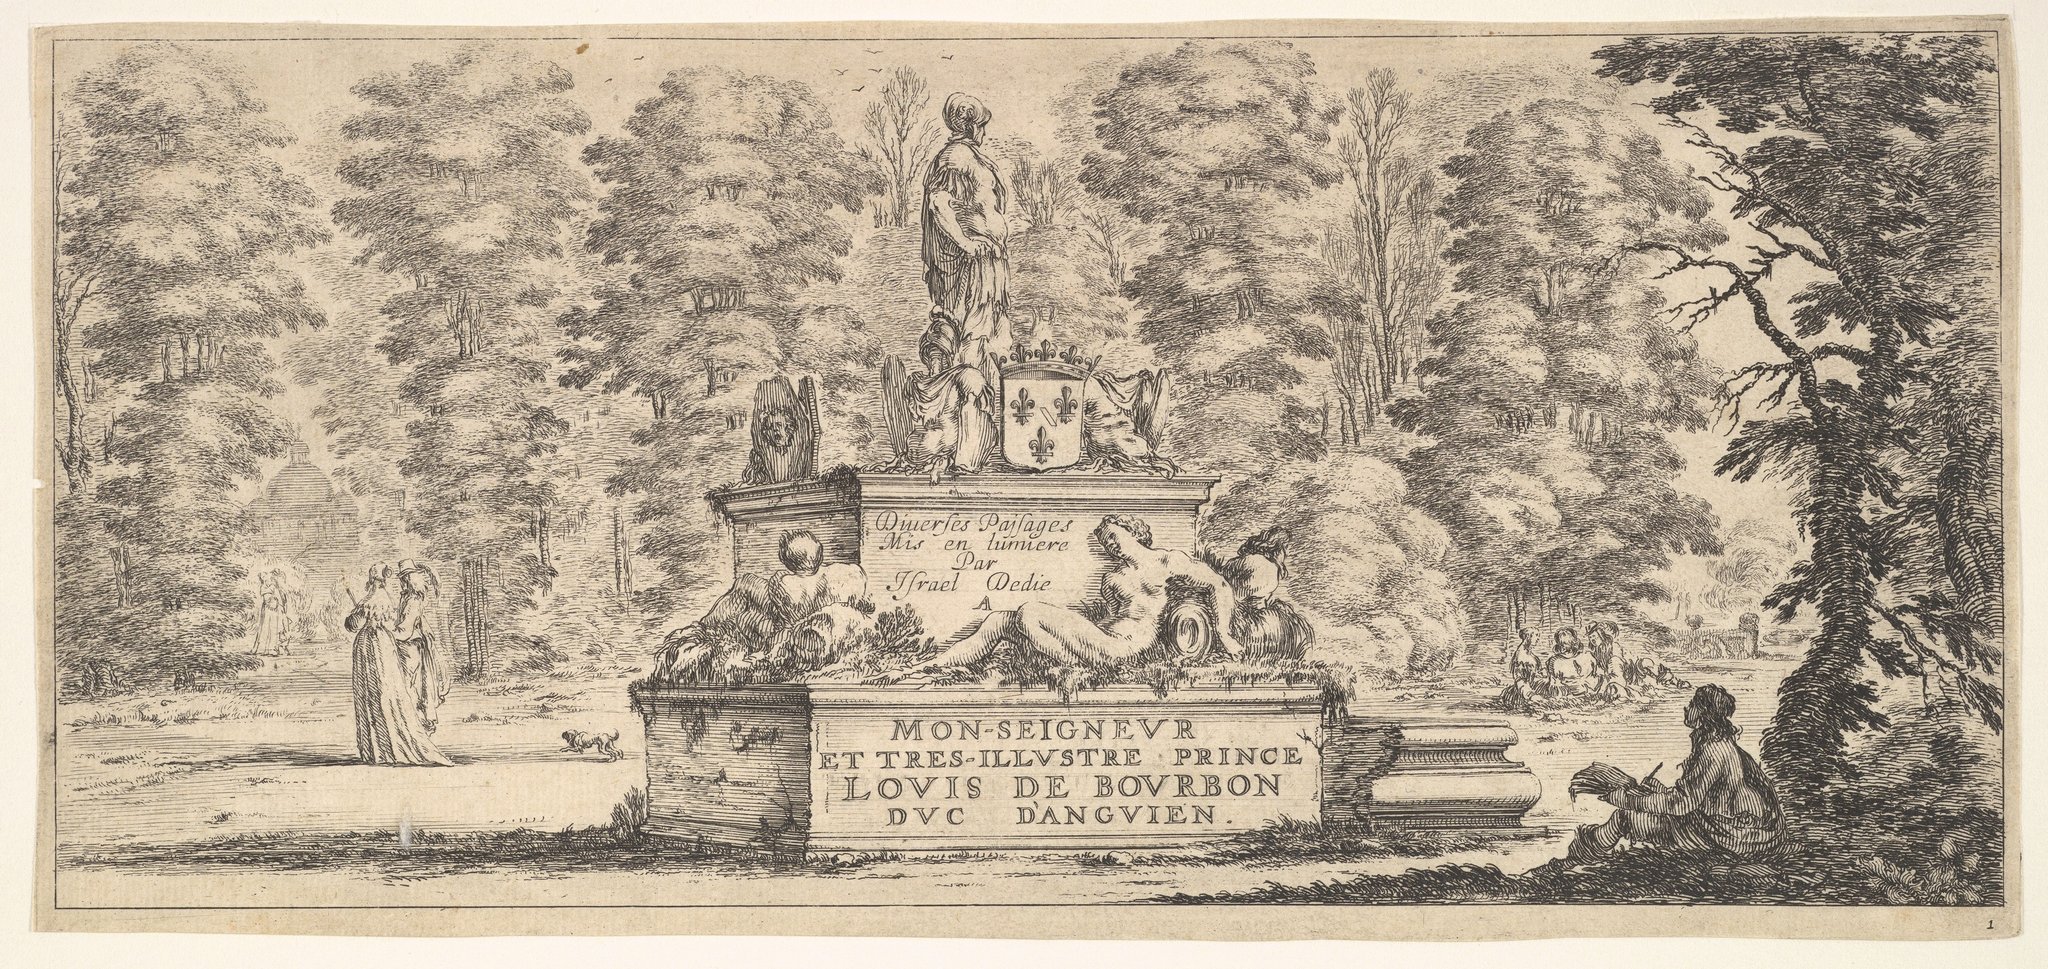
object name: print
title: Plate 1: a monument with statues and a coat of arms in the center, a draughstman on the ground beneath a tree to right, two pairs of lovers to left in the background, from "Various Landscapes" (Divers Paysages)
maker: stefano della bella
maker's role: artist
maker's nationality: italian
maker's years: 1610-1664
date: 1641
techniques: etching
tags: monuments,lovers,female nudes,coat of arms